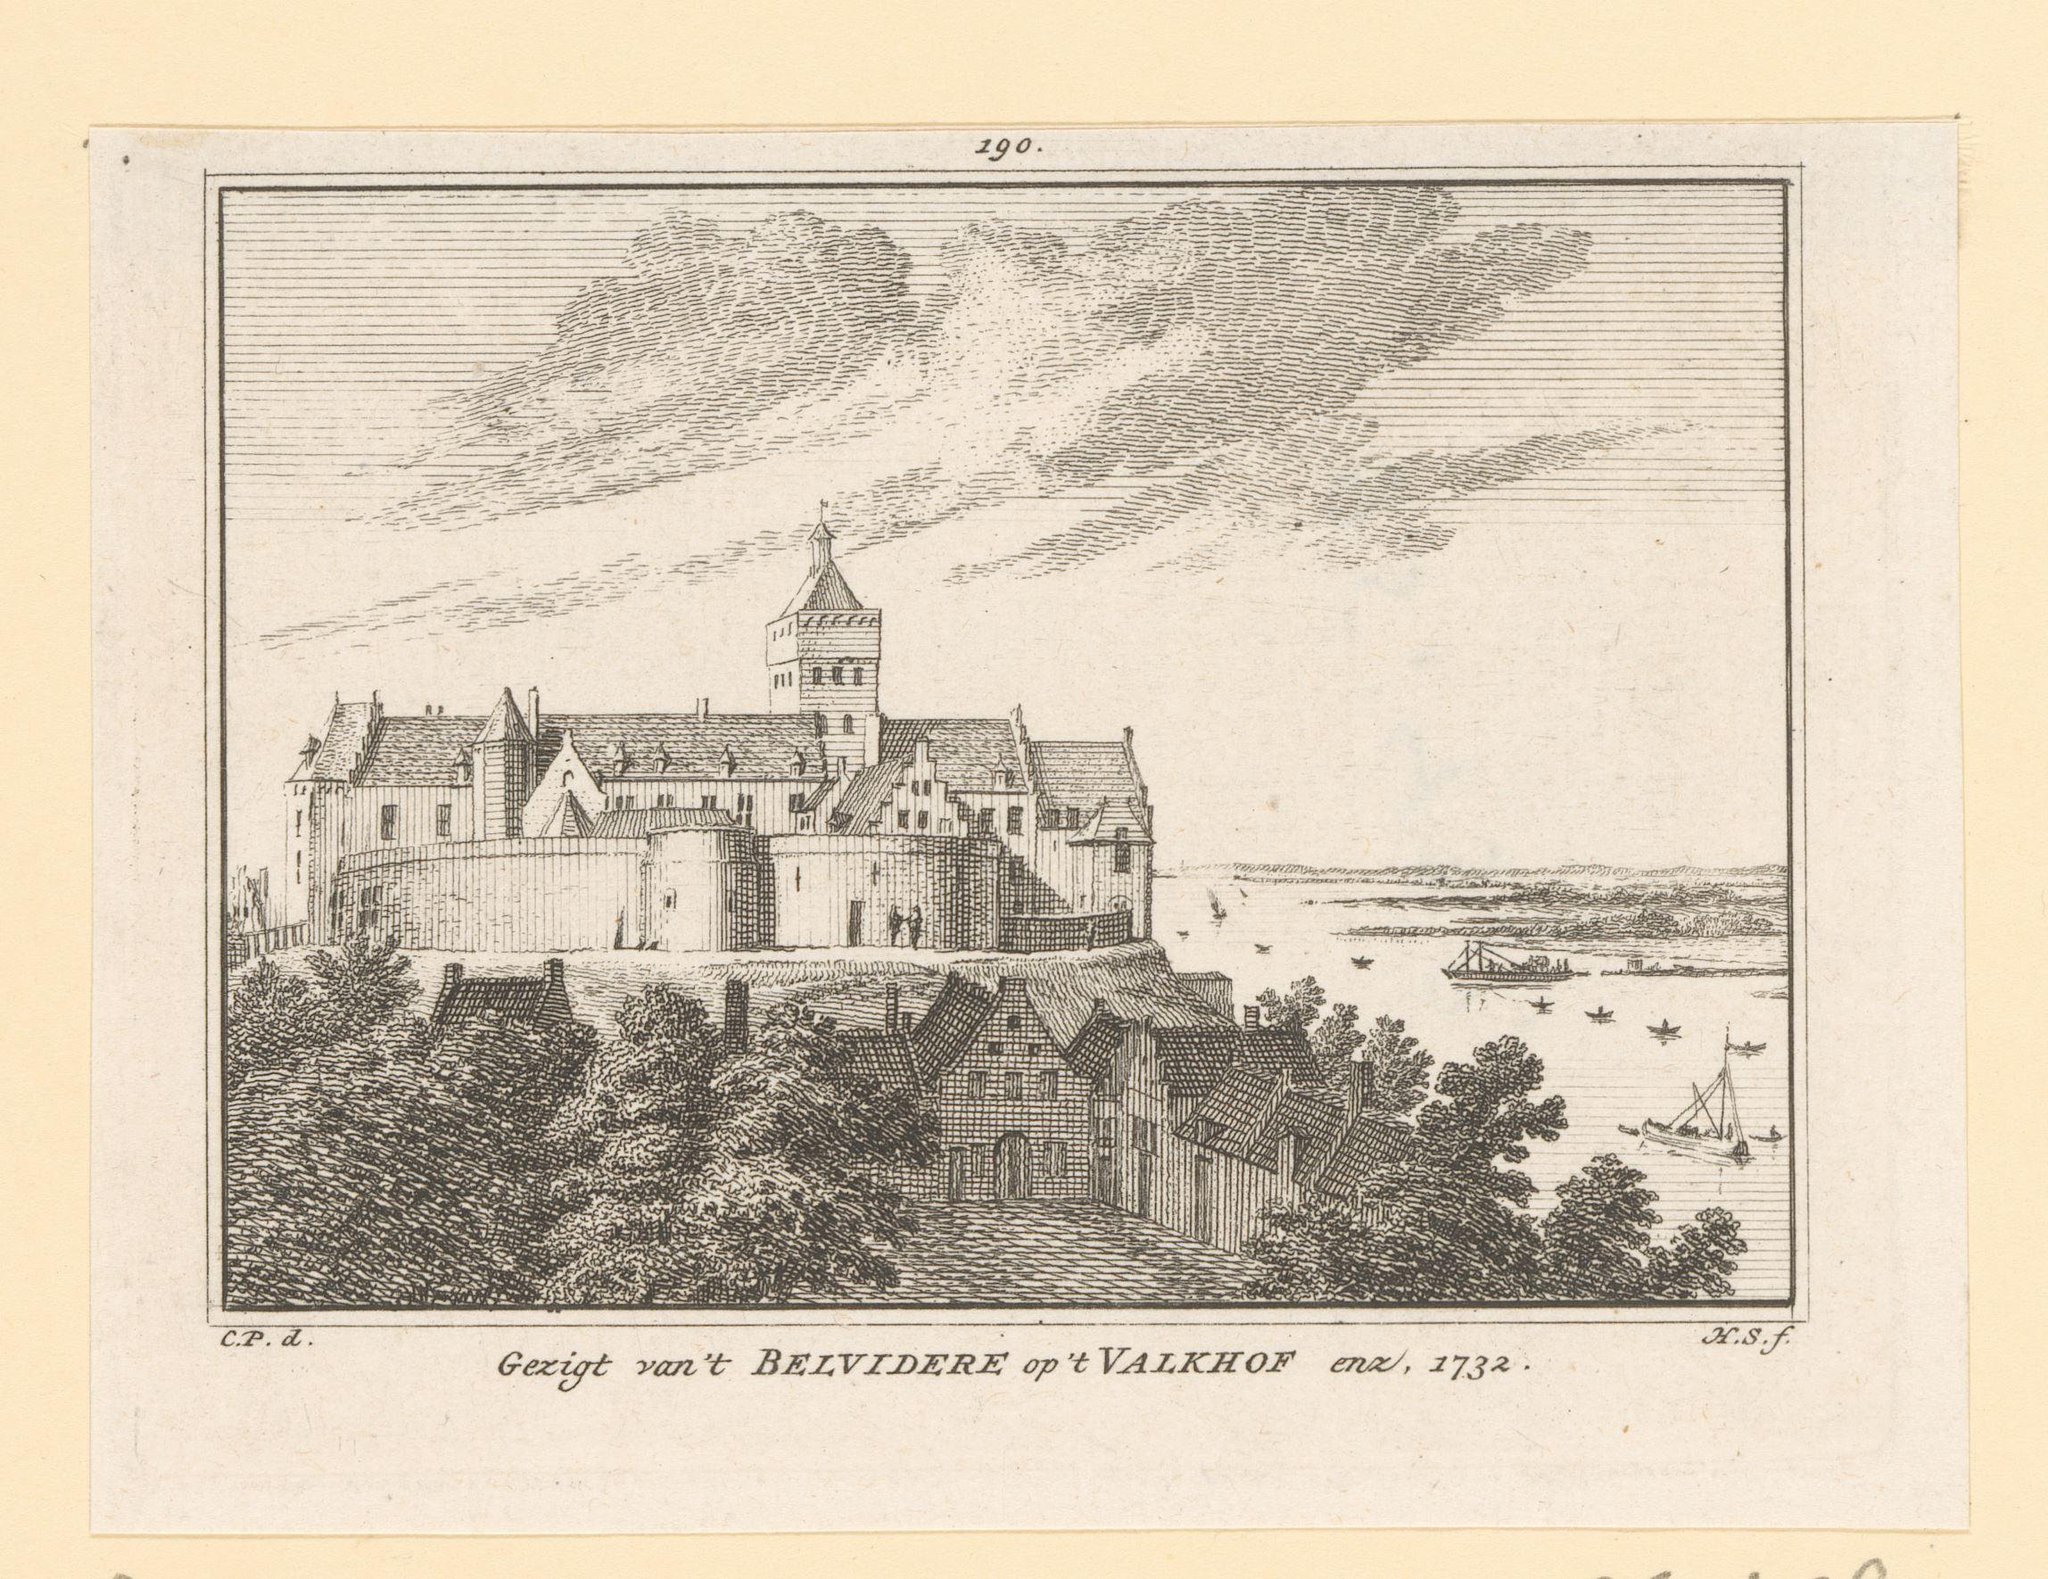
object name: print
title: Gezicht op het Valkhof vanaf de Belvédère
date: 1746-1792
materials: paper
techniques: etching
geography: amsterdam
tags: castle, towers ~ fortified city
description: Prent ook gebruikt in: Het verheerlykt Nederland of kabinet van hedendaagsche gezigten van steden, dorpen (…). 9 delen. Amsterdam: Isaak Tirion en weduwe Isaak Tirion, 1745-1774, dl. 2 (1746), ill. 190. Of in: Nederlandsche tafereelen; of eene keurige verzameling van negen honderd fraaije gezigten van steden, dorpen, sloten, oudheden (….). 9 delen. Amsterdam: Jan de Groot, 1792, dl. 2, ill. 190.